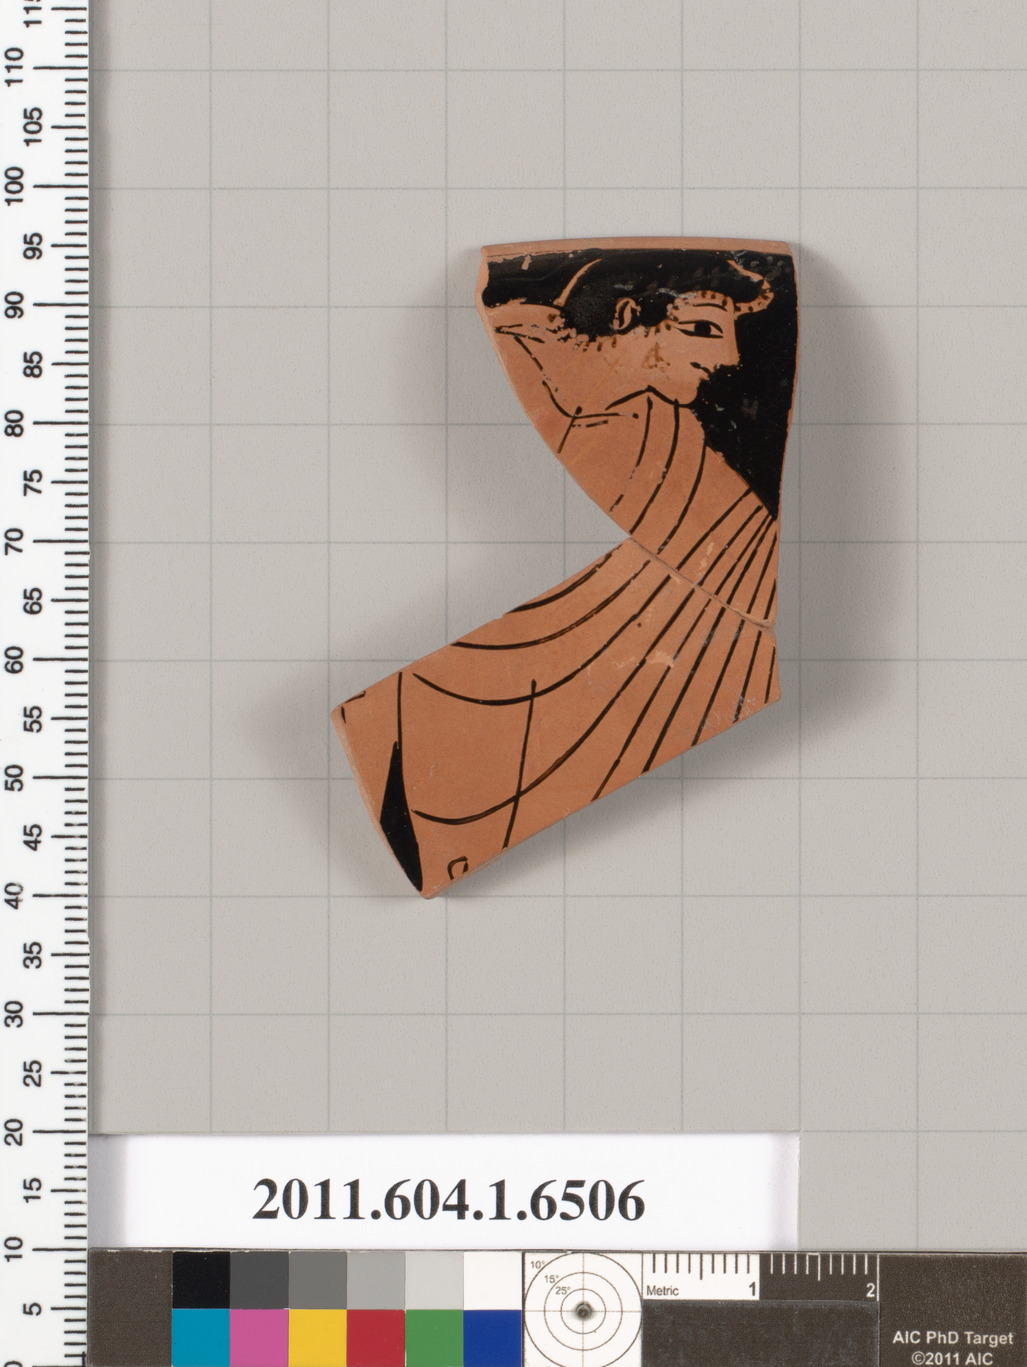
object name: kylix fragment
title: Terracotta rim fragment of a kylix (drinking cup)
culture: greek, attic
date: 490-480 BCE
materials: terracotta